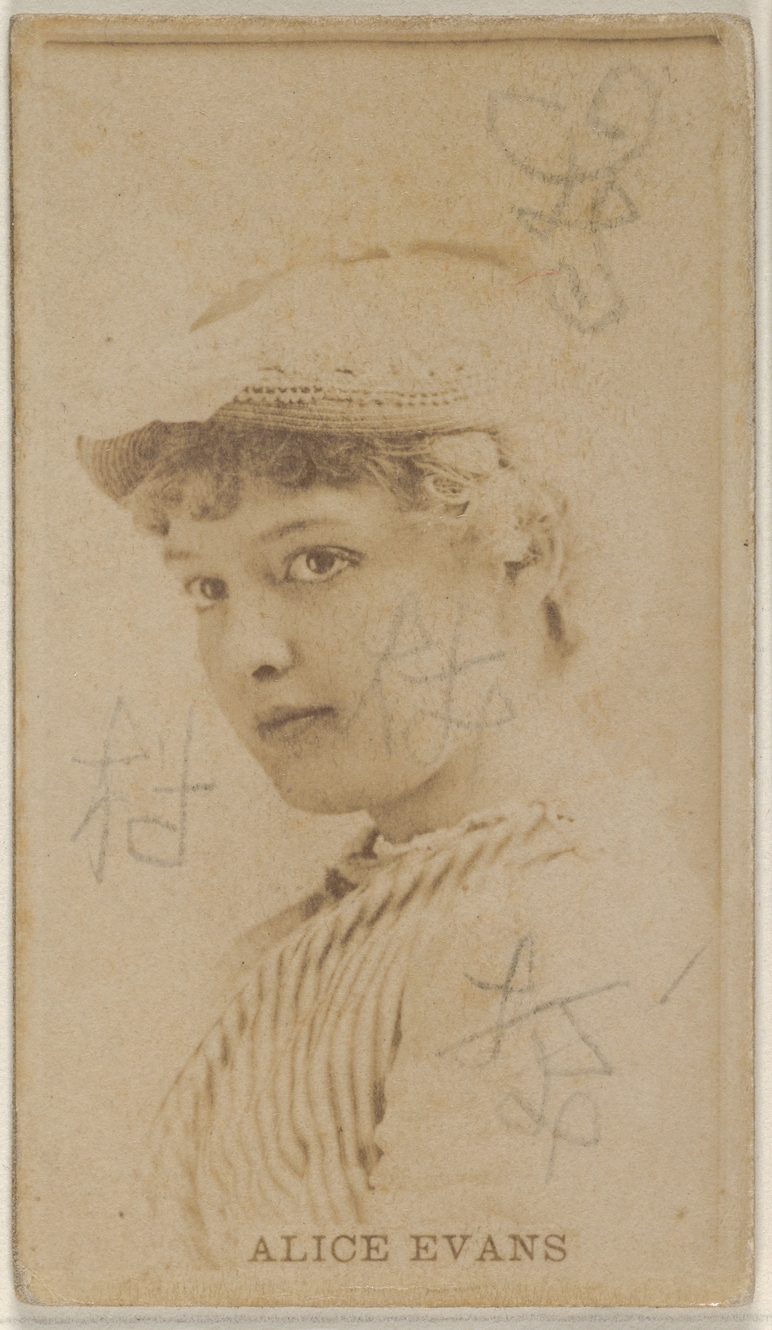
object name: photograph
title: Alice Evans, from the Actors and Actresses series (N45, Type 8) for Virginia Brights Cigarettes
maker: allen & ginter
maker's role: publisher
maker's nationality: american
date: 1888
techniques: albumen silver print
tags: portraits,women,actresses